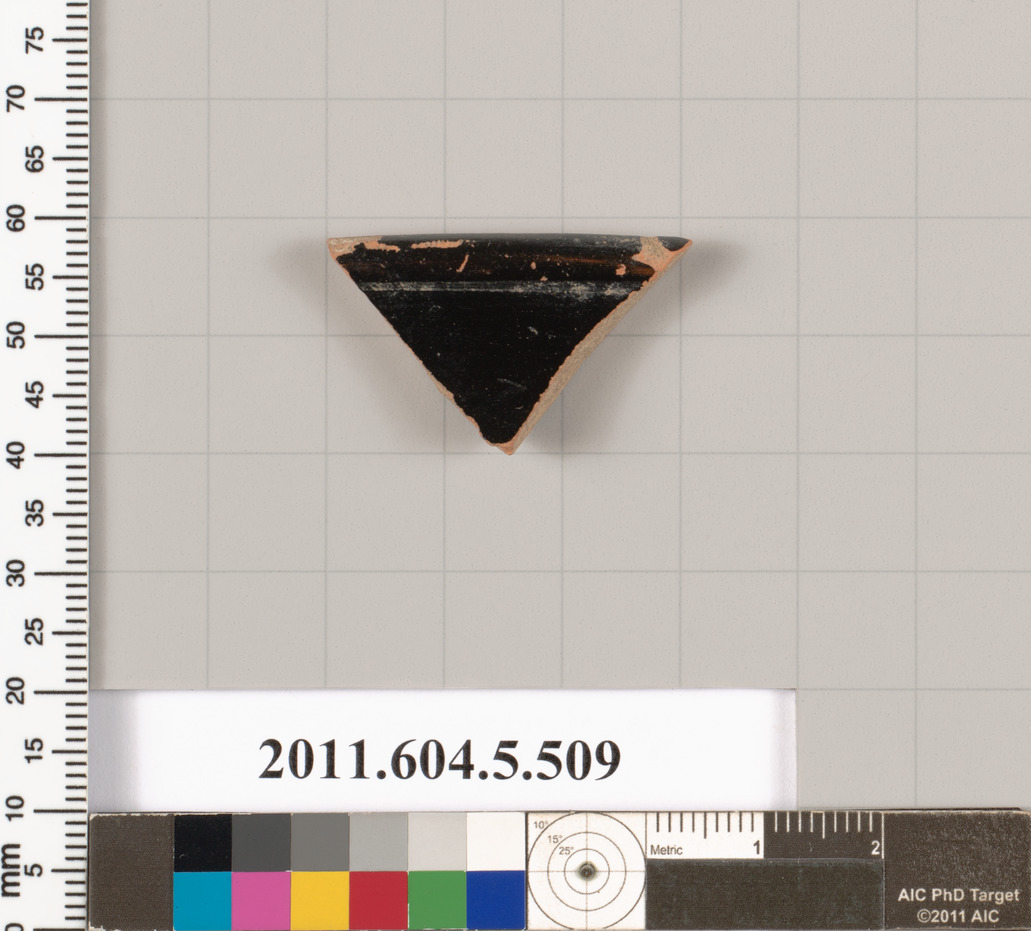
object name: kylix fragment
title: Terracotta fragment of a kylix (drinking cup)?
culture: greek, attic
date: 600-401 BCE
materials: terracotta